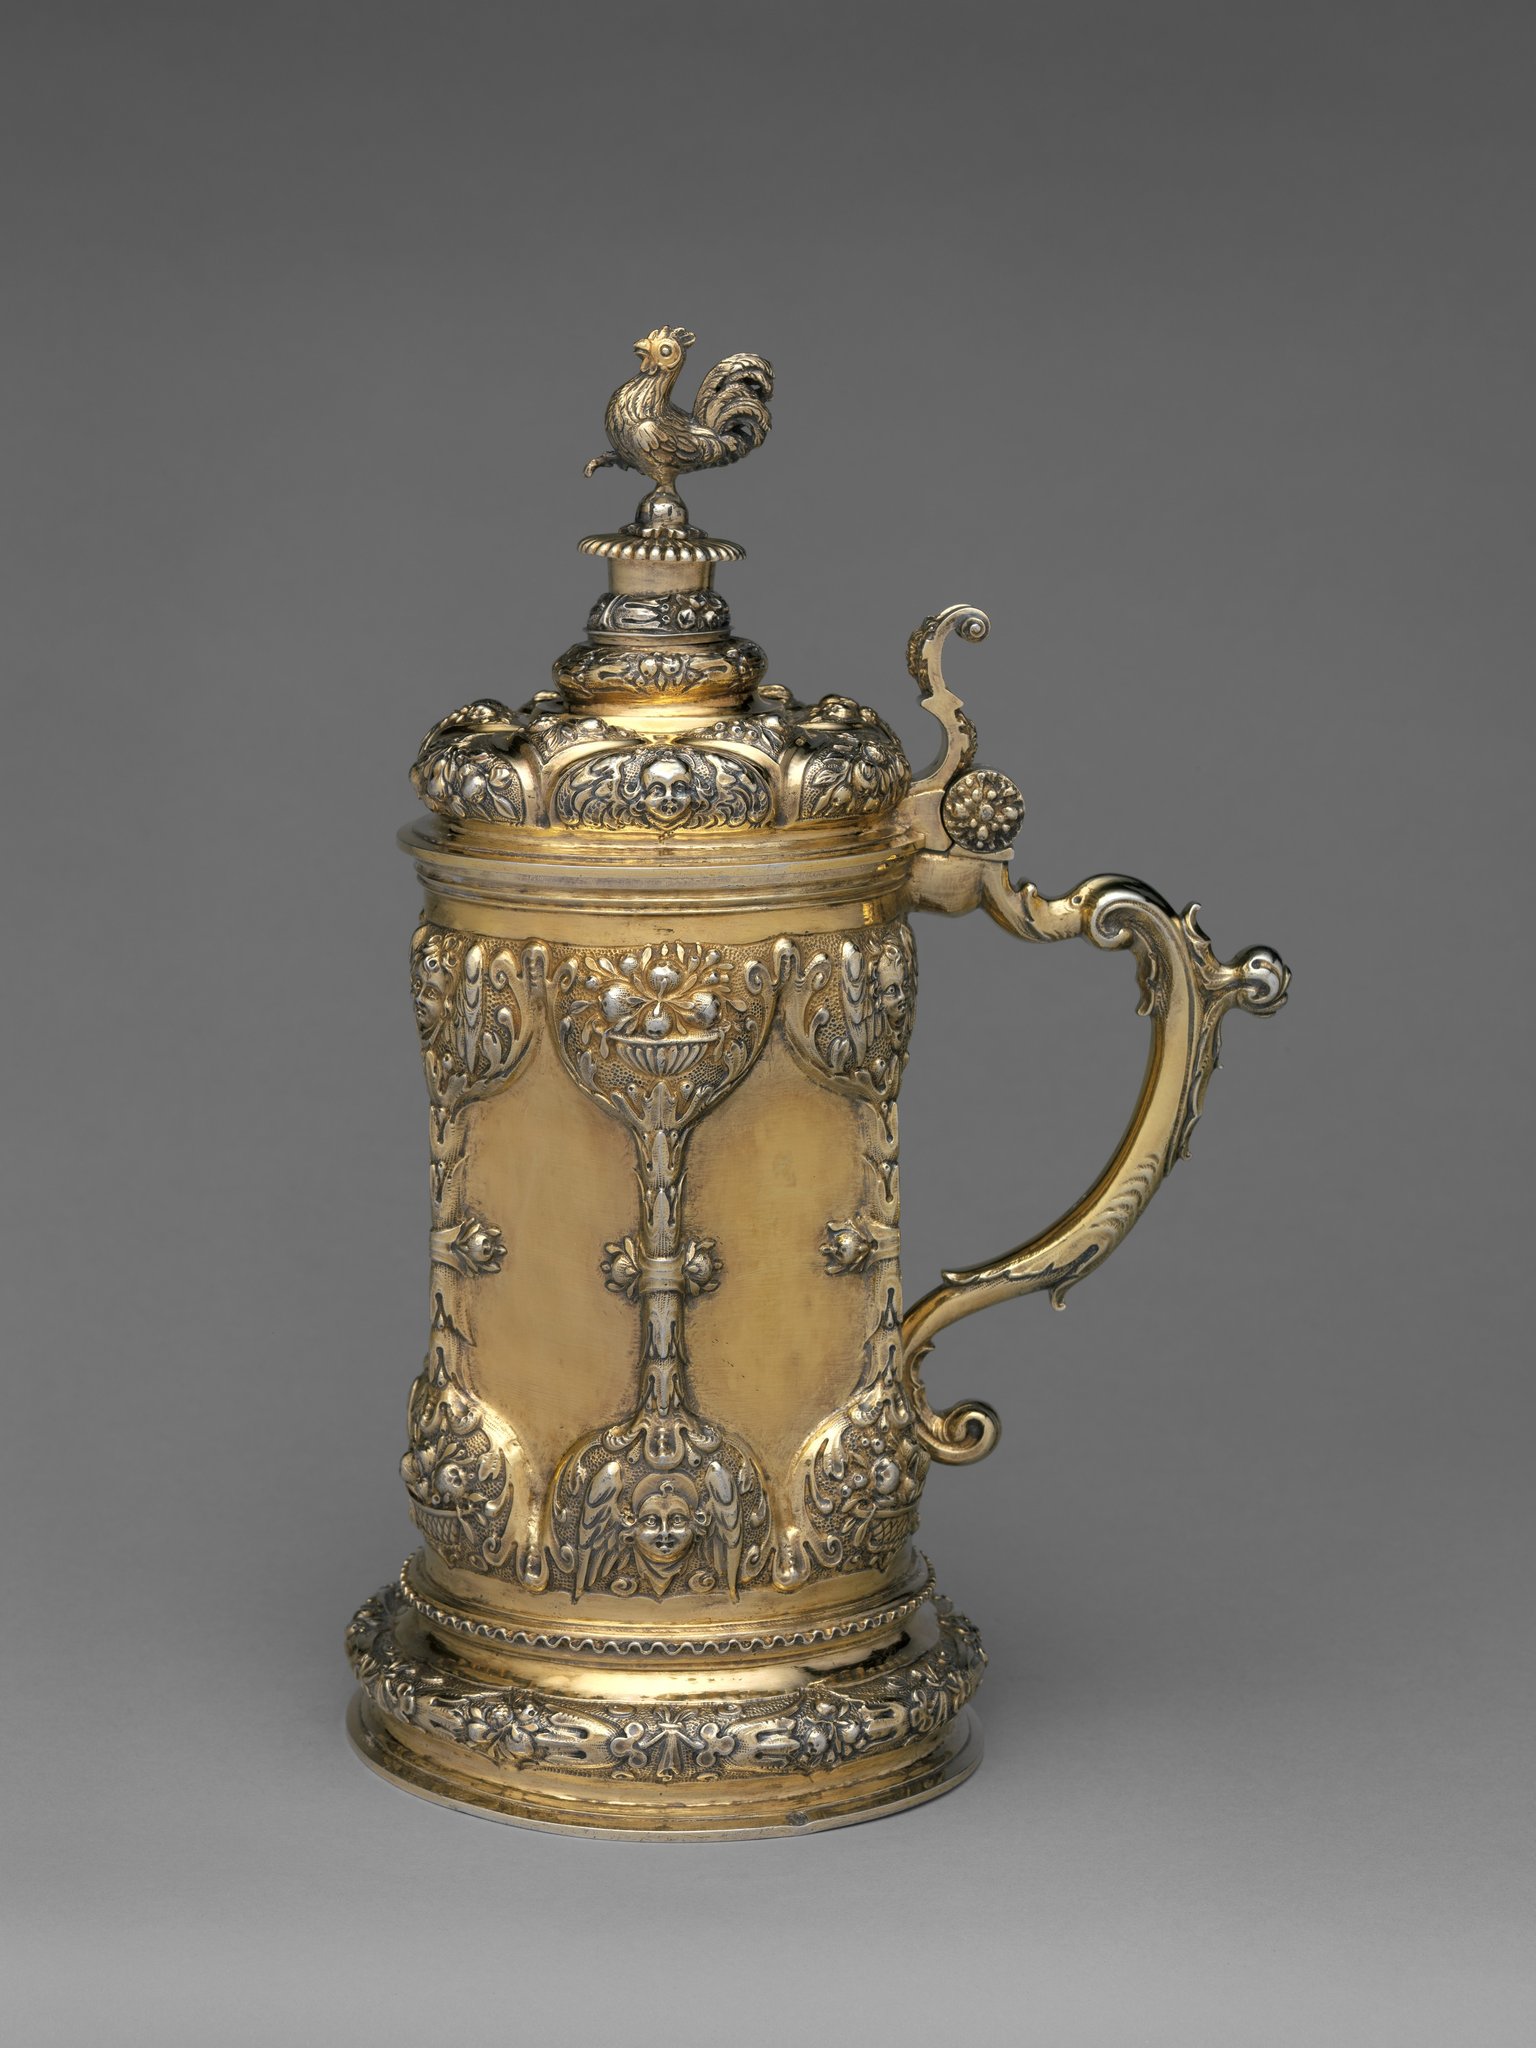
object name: tankard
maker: georgius olescher sr.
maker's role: maker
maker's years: 1607-1707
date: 1667-1700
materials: gilt silver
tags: roosters